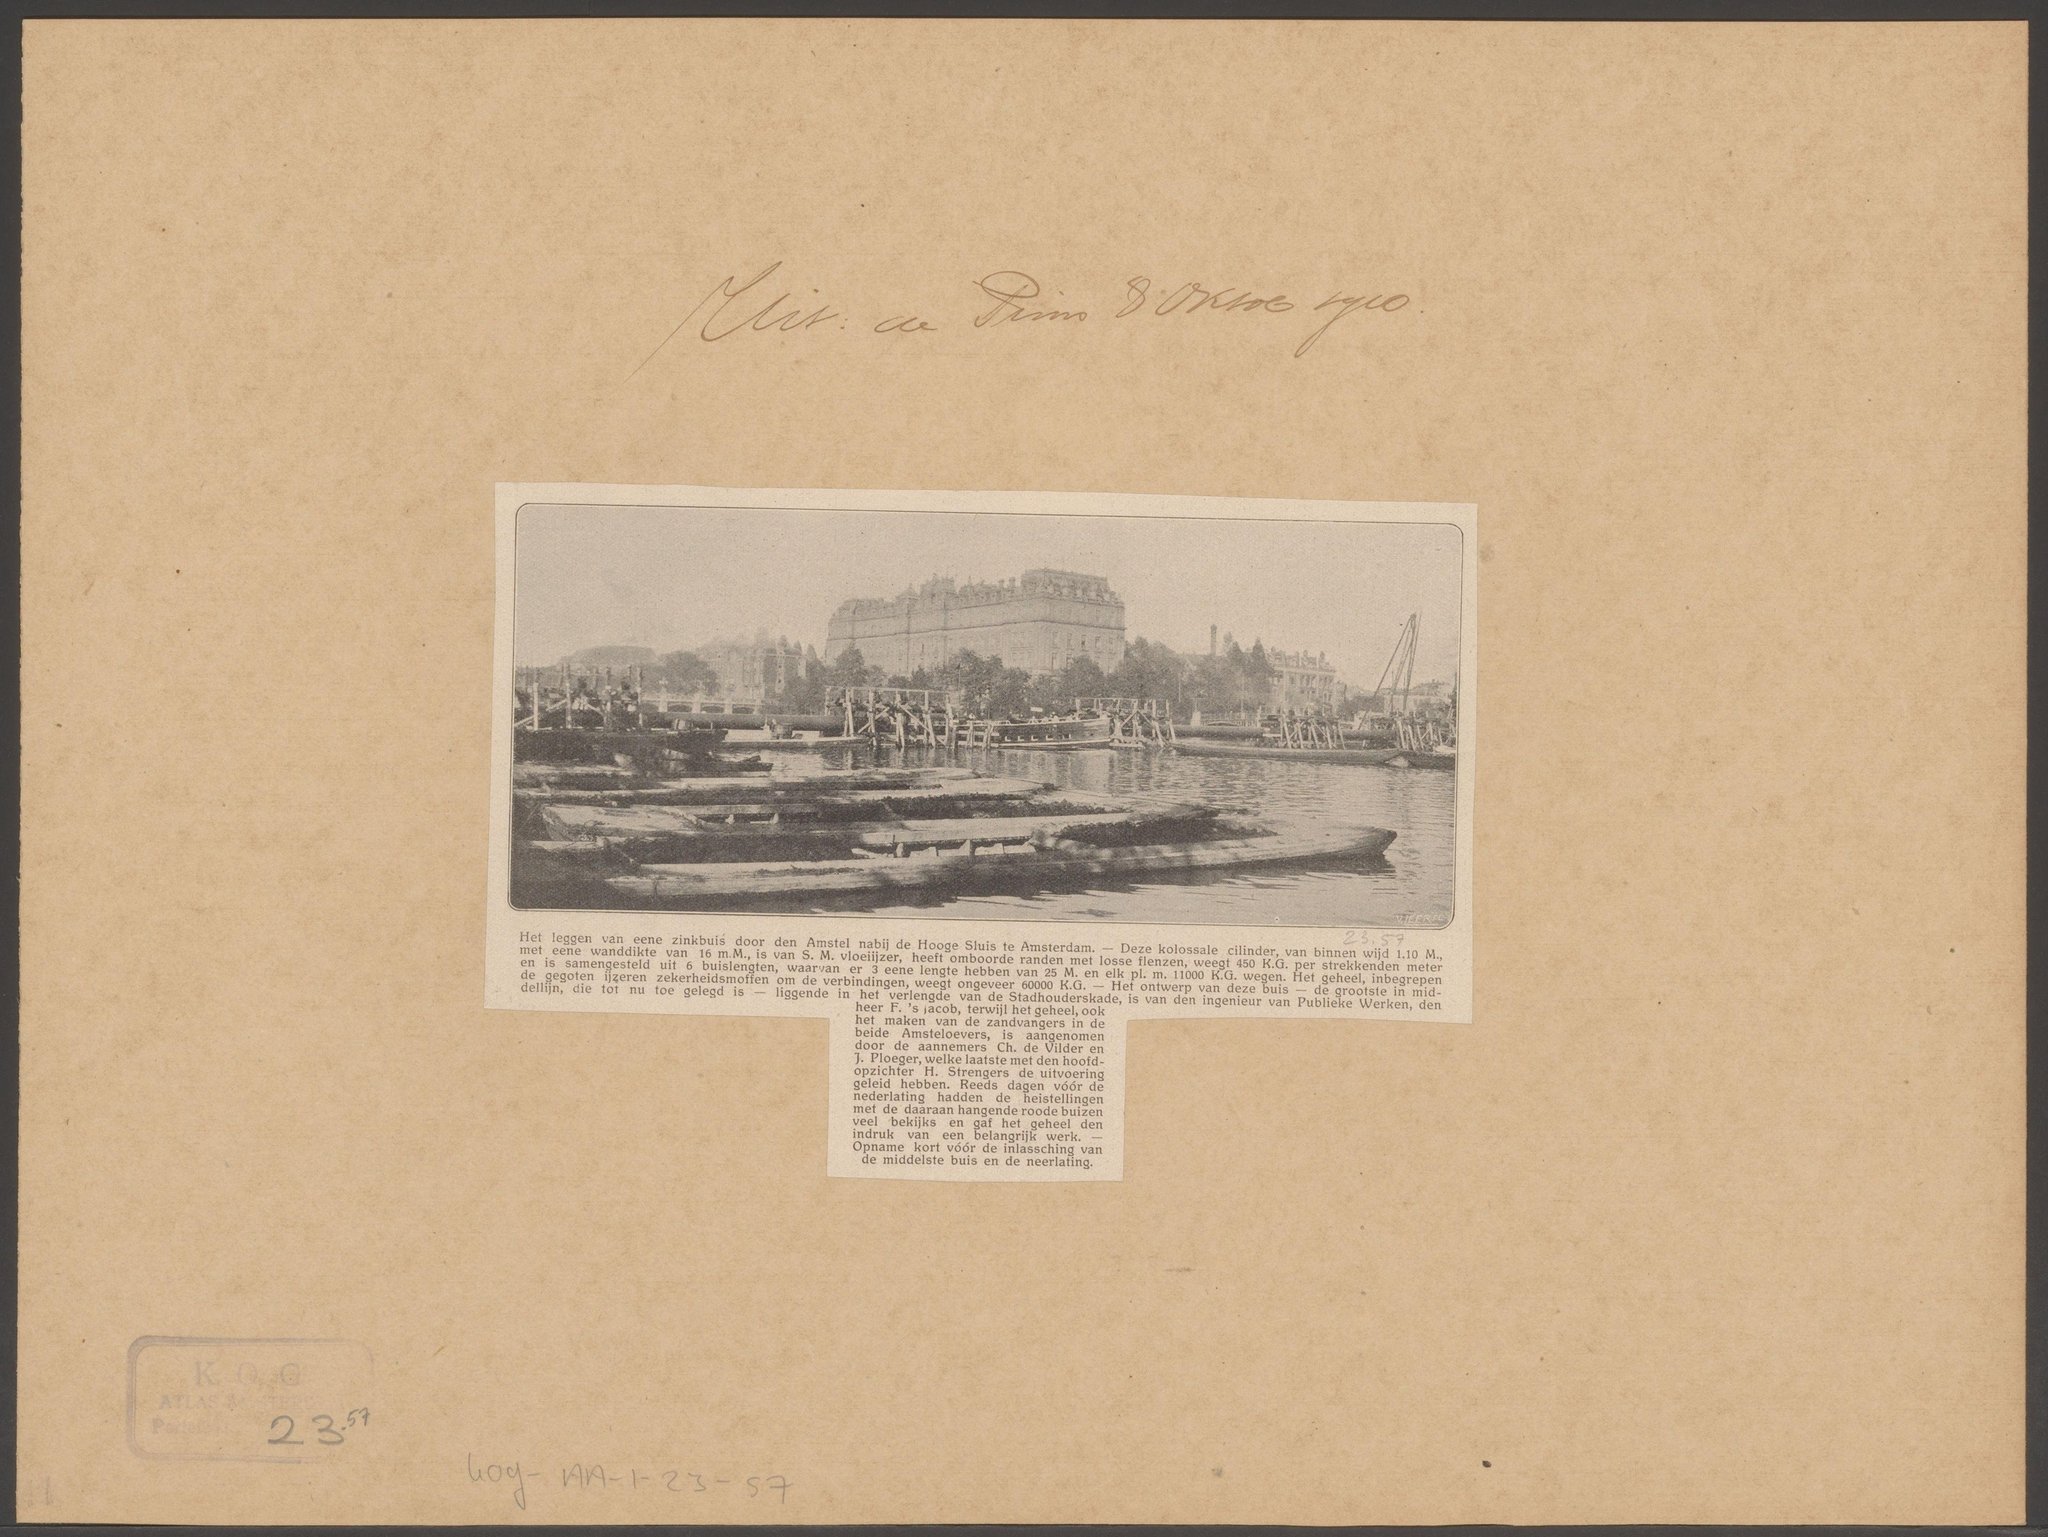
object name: photomechanical print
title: Aanleg van een rioolsbuis in de Amstel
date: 1910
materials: paper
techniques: letterpress printing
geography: amsterdam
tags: sewers, canals, waters (in city)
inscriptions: collector's mark: Lugt 1641b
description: Onderwerpsrubriek binnen de Atlas Amsterdam: Gemeentebedrijven.